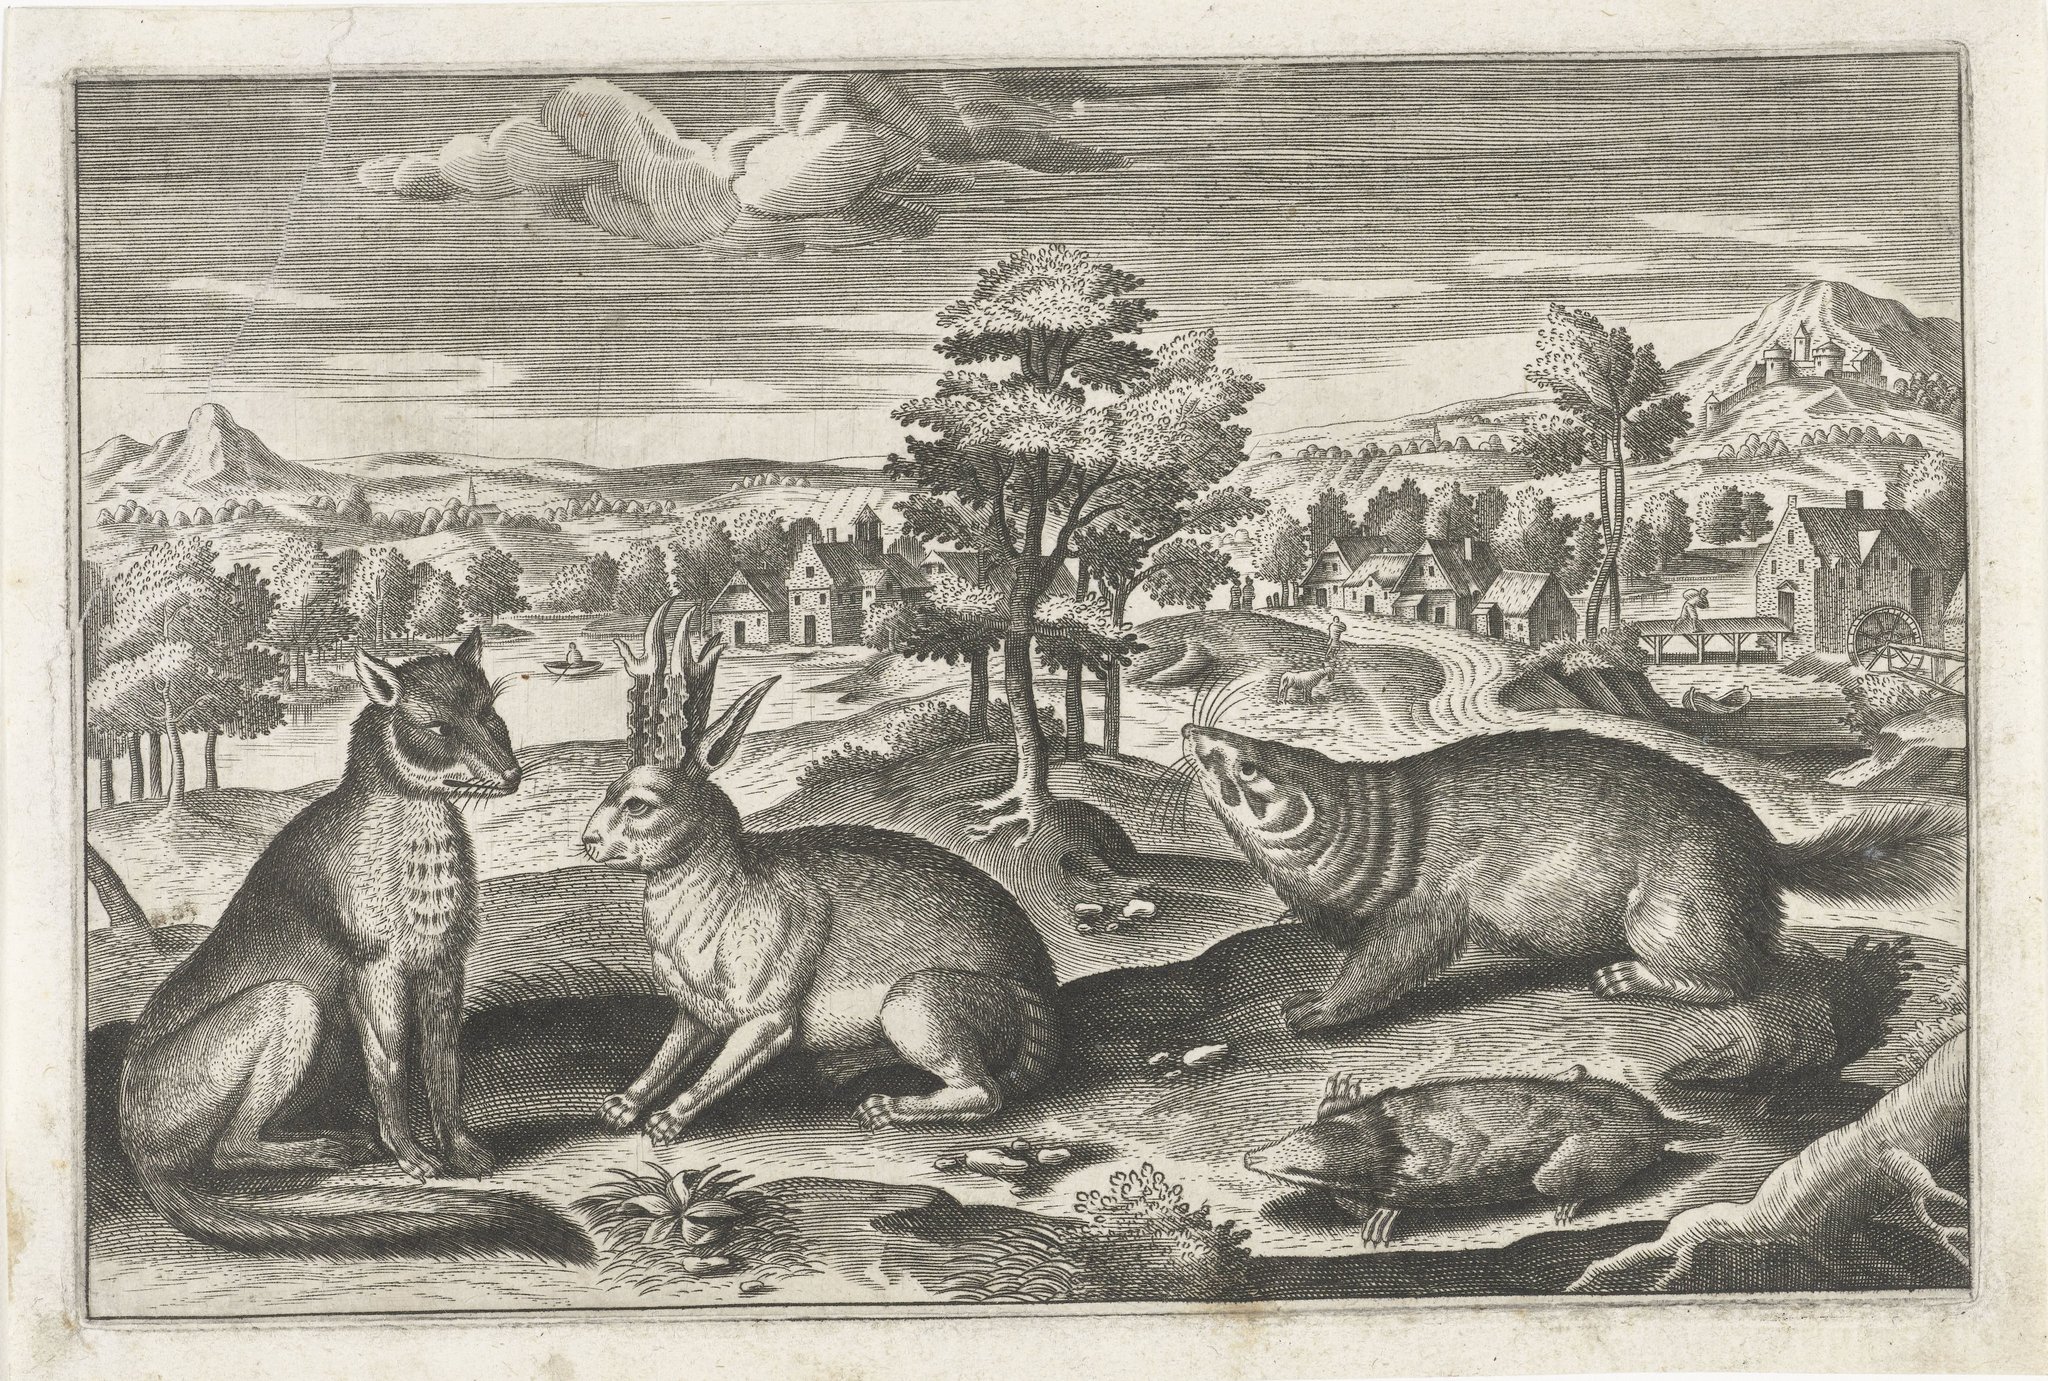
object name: print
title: Bosdieren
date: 1595-1652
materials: paper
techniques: engraving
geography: amsterdam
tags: other mammals: mole, village, beasts of prey, predatory animals: badger, rodents: hare (+ antlers; horn), beasts of prey, predatory animals: fox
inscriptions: collector's mark: Lugt 2228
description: Op de voorgrond een vos, een mol, een das en een gehoornde haas. Op de achtergrond een landschap met een dorp. De prent maakt deel uit van een serie met als onderwerp dieren.